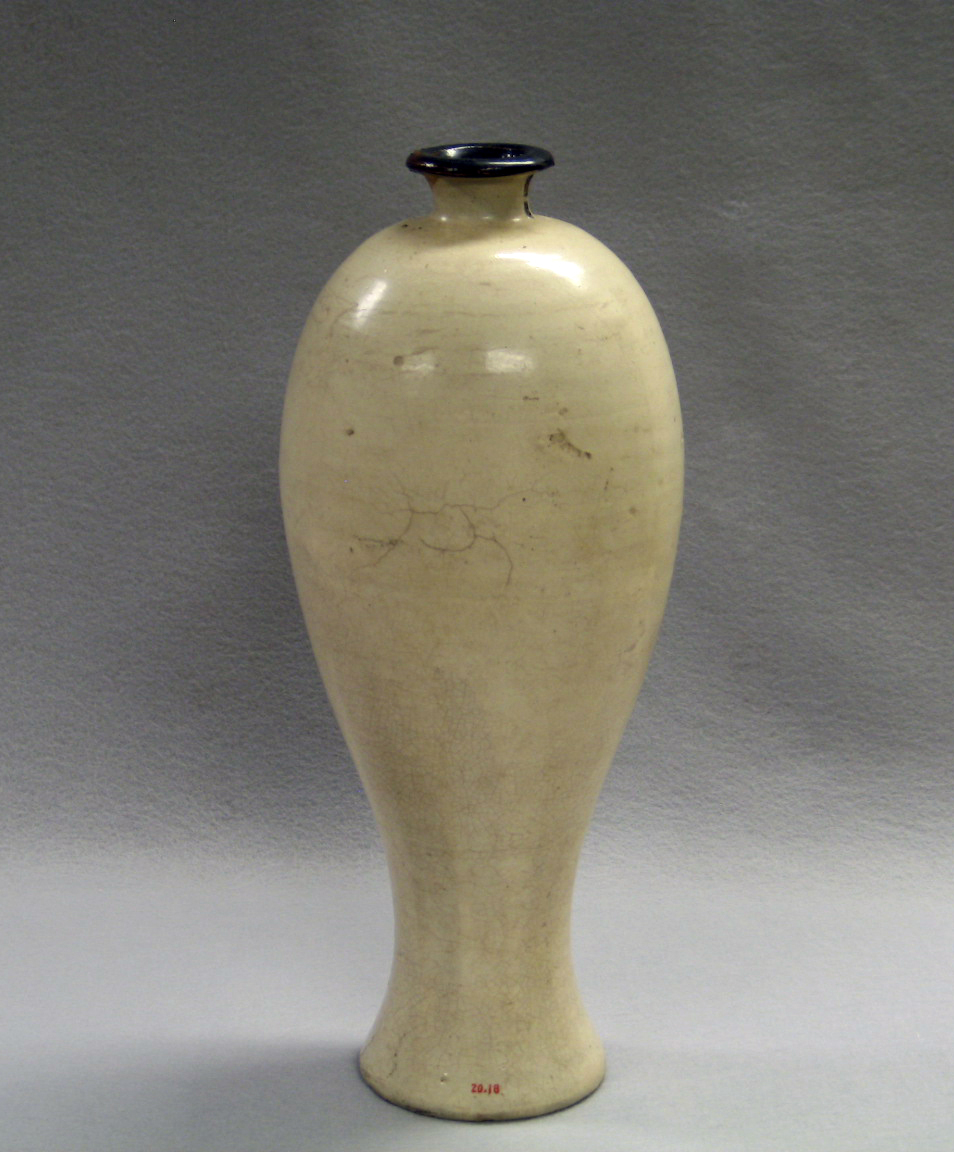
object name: jar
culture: chinese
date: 1301-1400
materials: glaze, stoneware